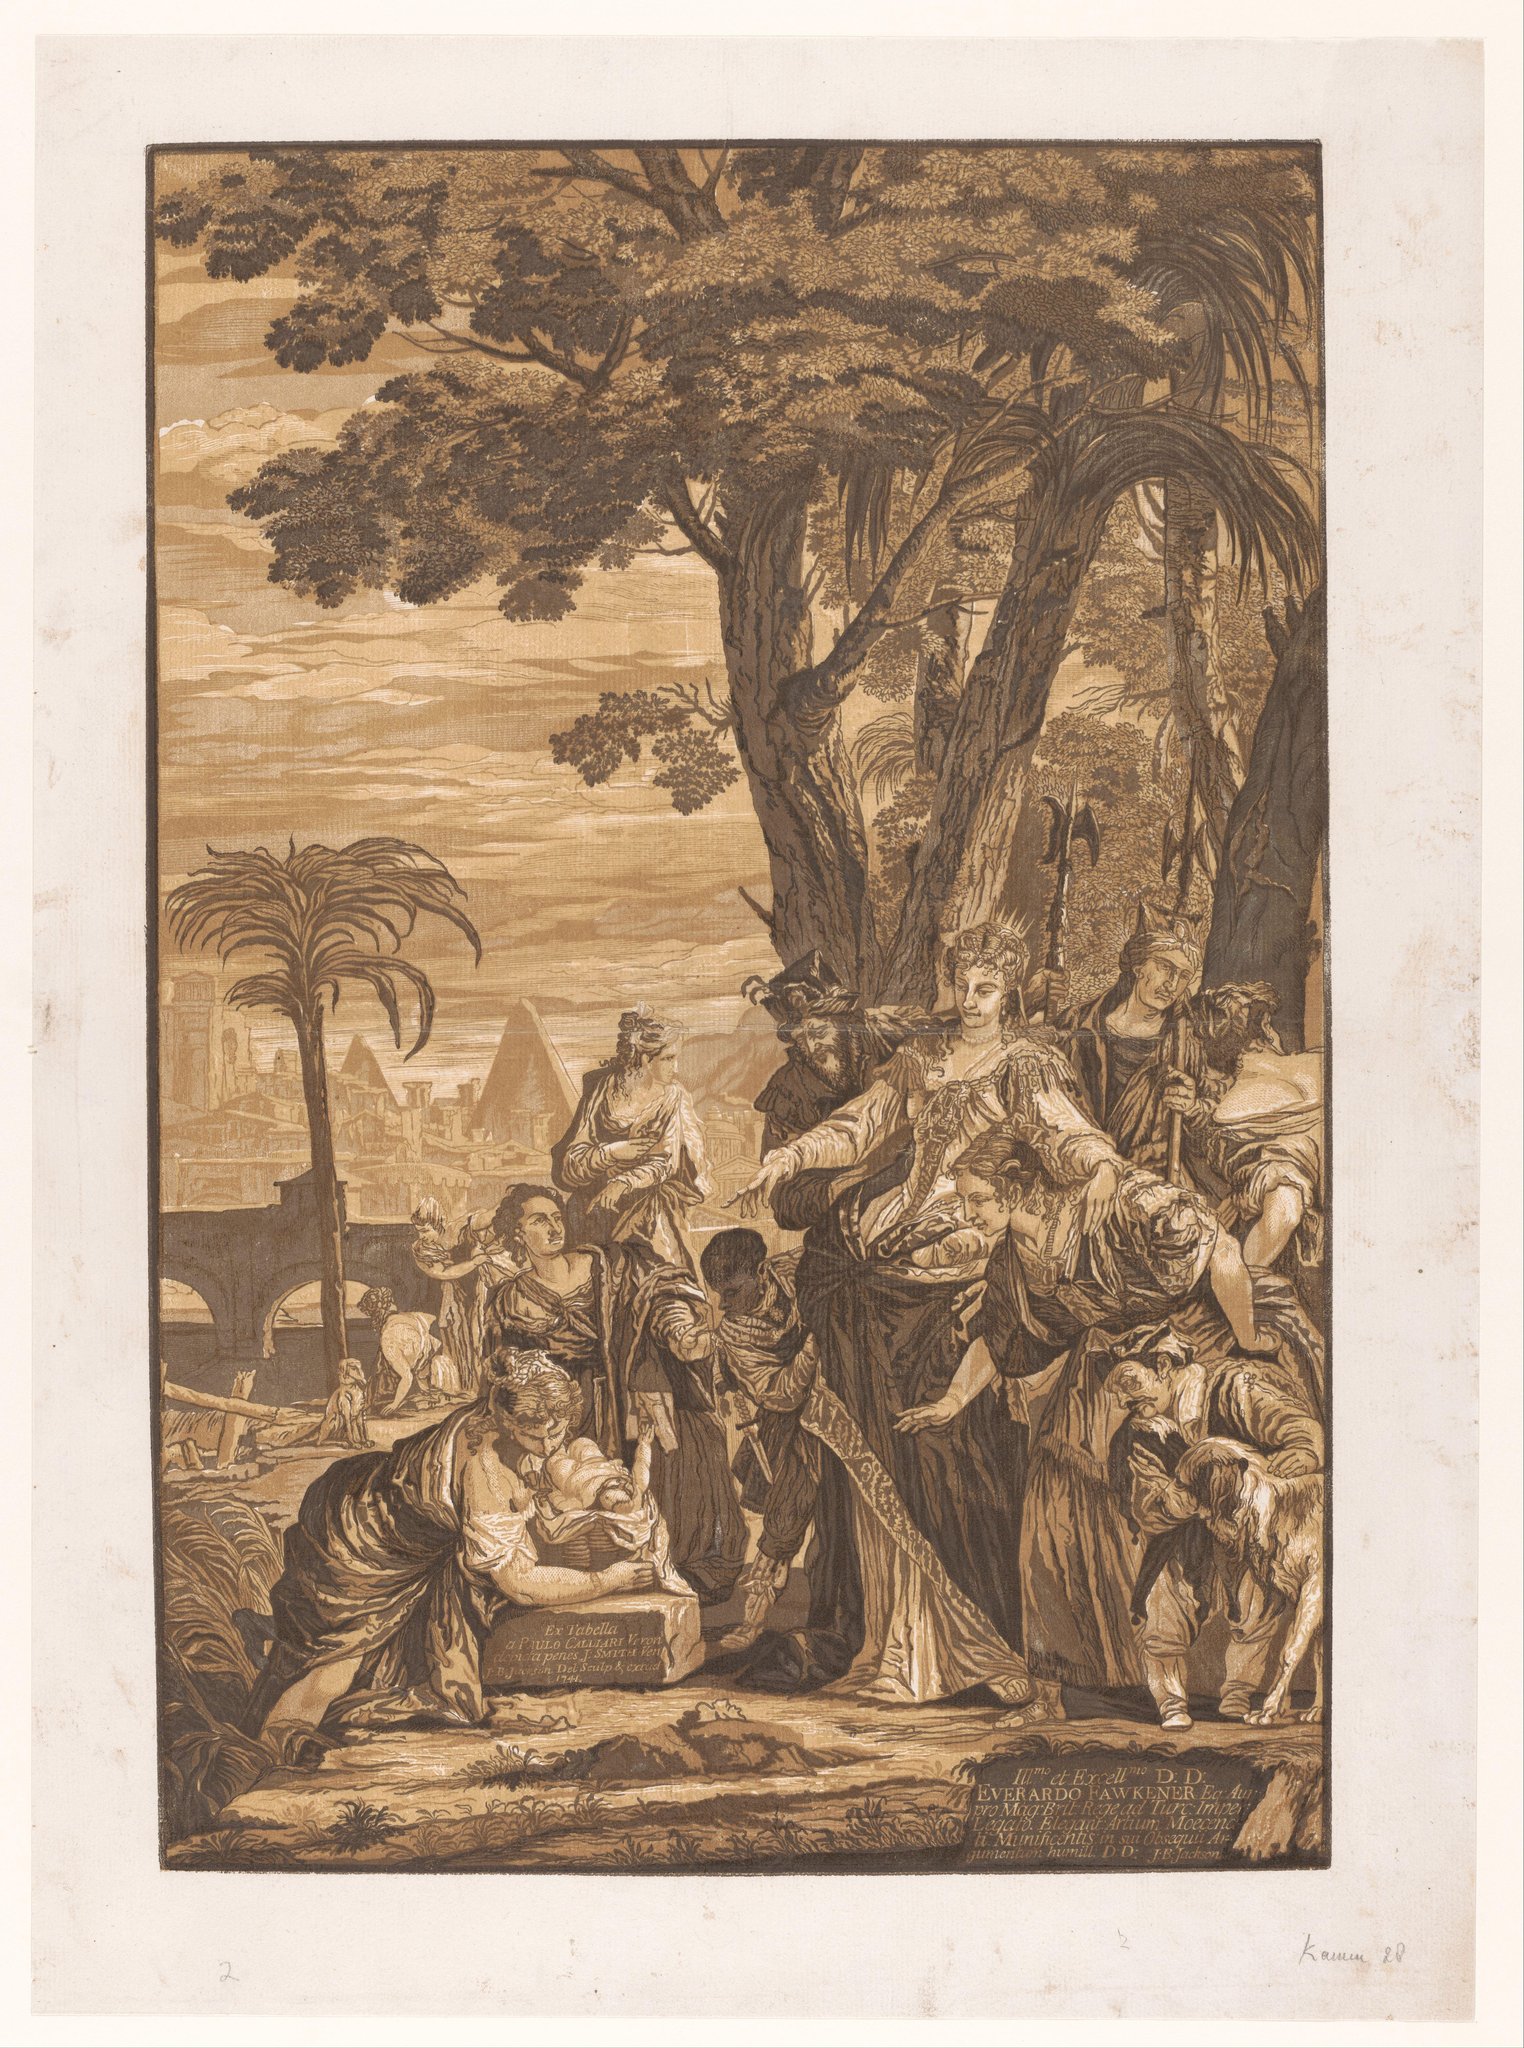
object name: print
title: Mozes wordt gevonden door de dochter van de farao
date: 1745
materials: paper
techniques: woodcut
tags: moses is pulled out of the water by the servants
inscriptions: collector's mark: Lugt 2228, collector's mark: Lugt 2760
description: Prent maakt deel uit van een ongenummerde serie van 24 prenten.